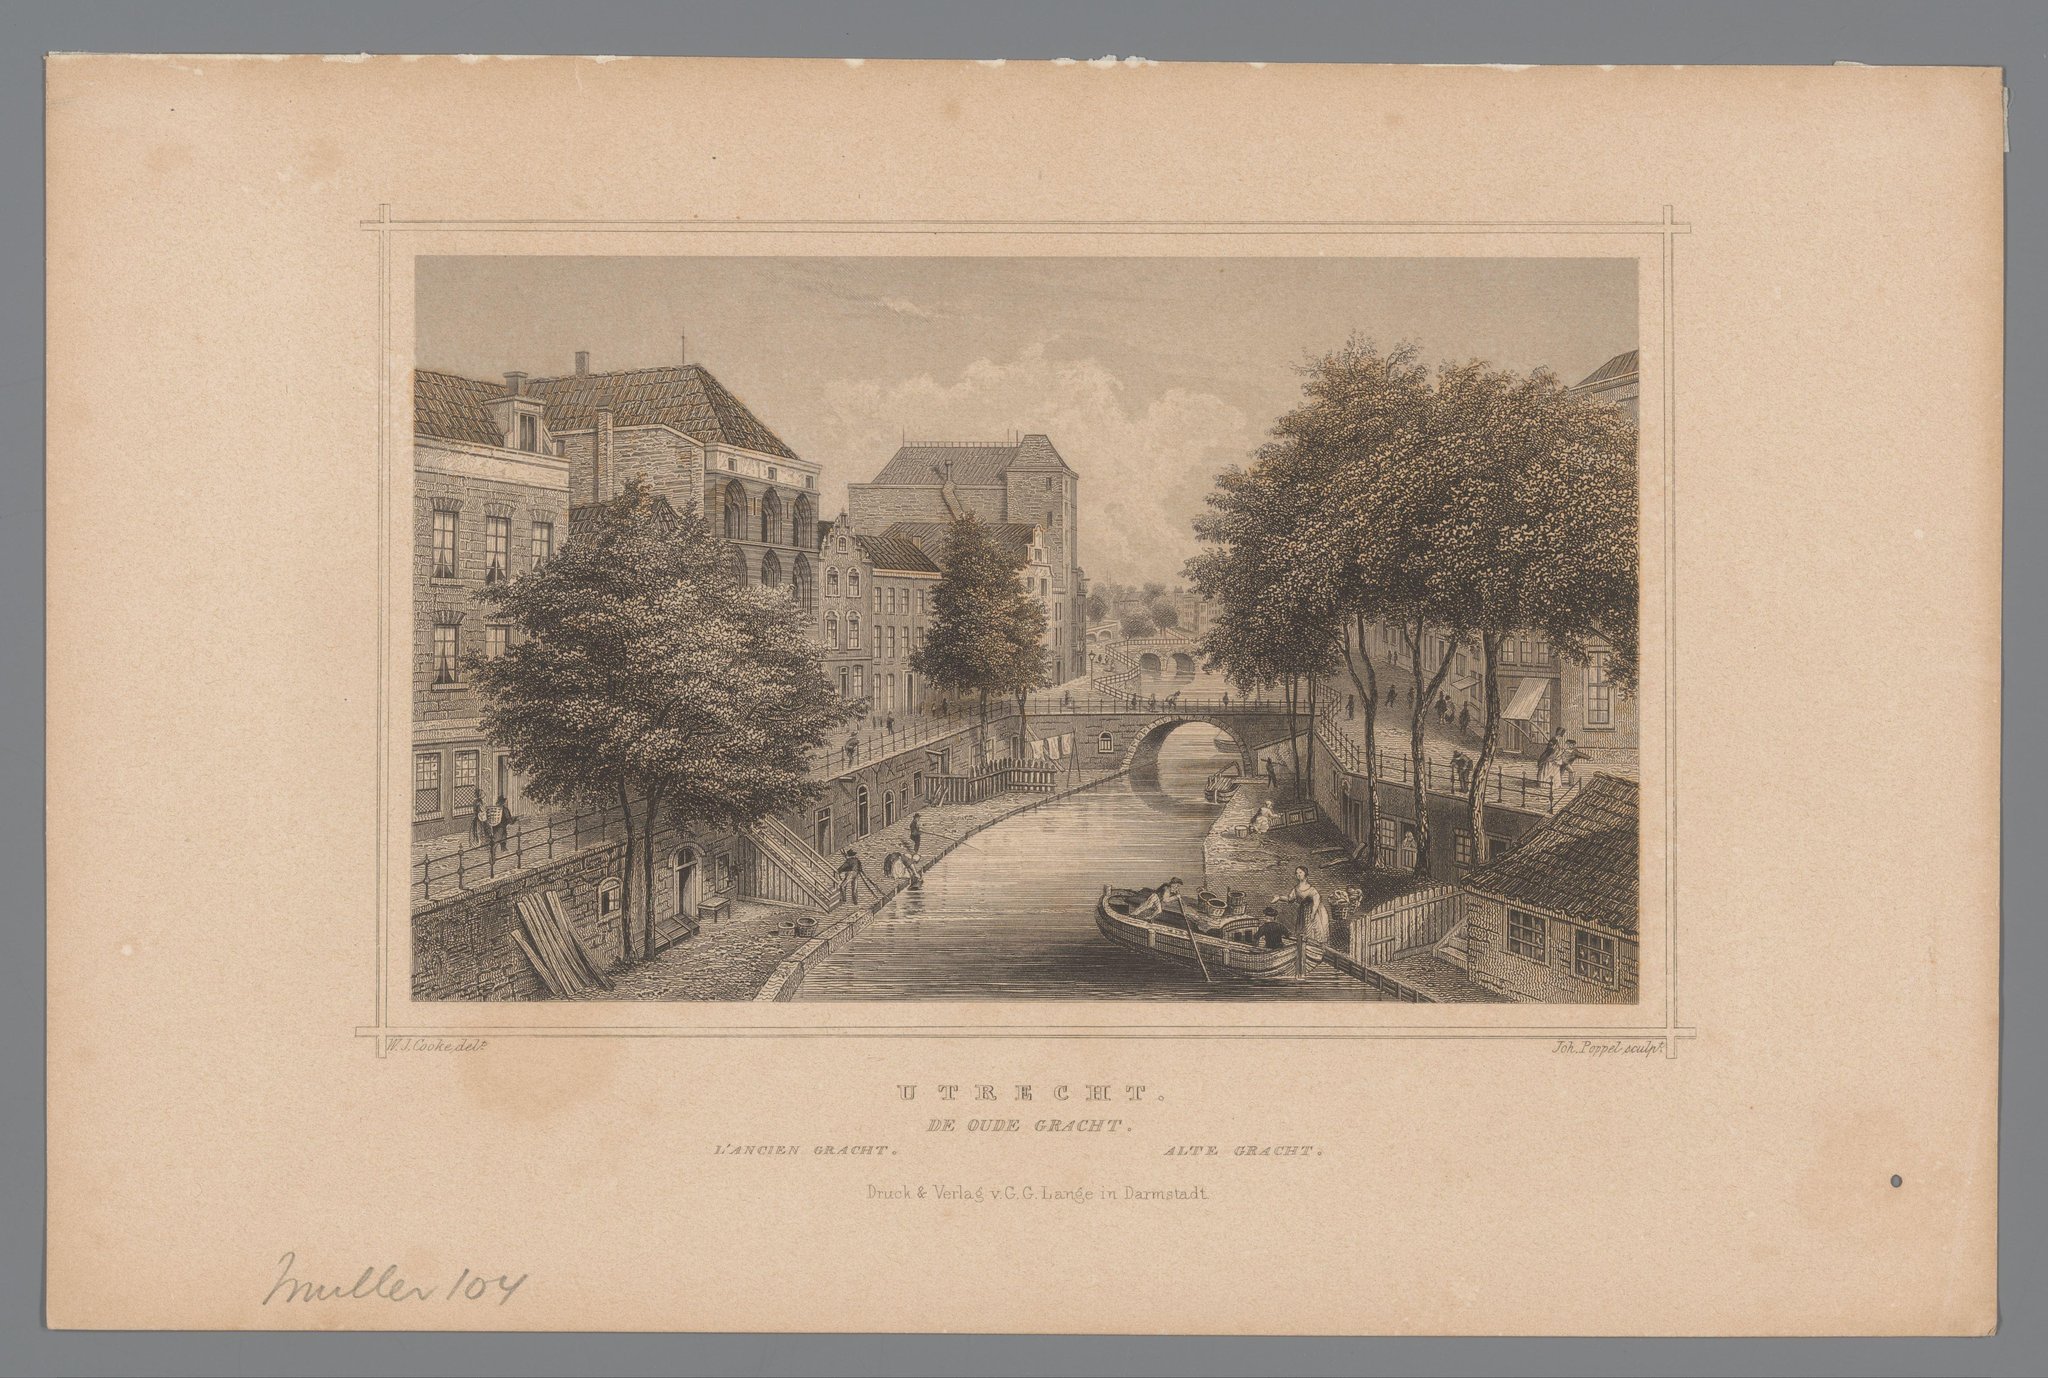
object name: print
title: Gezicht op de Oudegracht in Utrecht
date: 1863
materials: paper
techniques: engraving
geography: darmstadt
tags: city-view, and landscape with man-made constructions, canals, waters (in city), utrecht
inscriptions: collector's mark: Lugt 2233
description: Prent uit: Terwen, J.L. Het koningrijk der Nederlanden voorgesteld in eene reeks van 136 naar de natuur geteekende schilderachtige gezigten. Darmstadt: G.G. Lange, 1863.